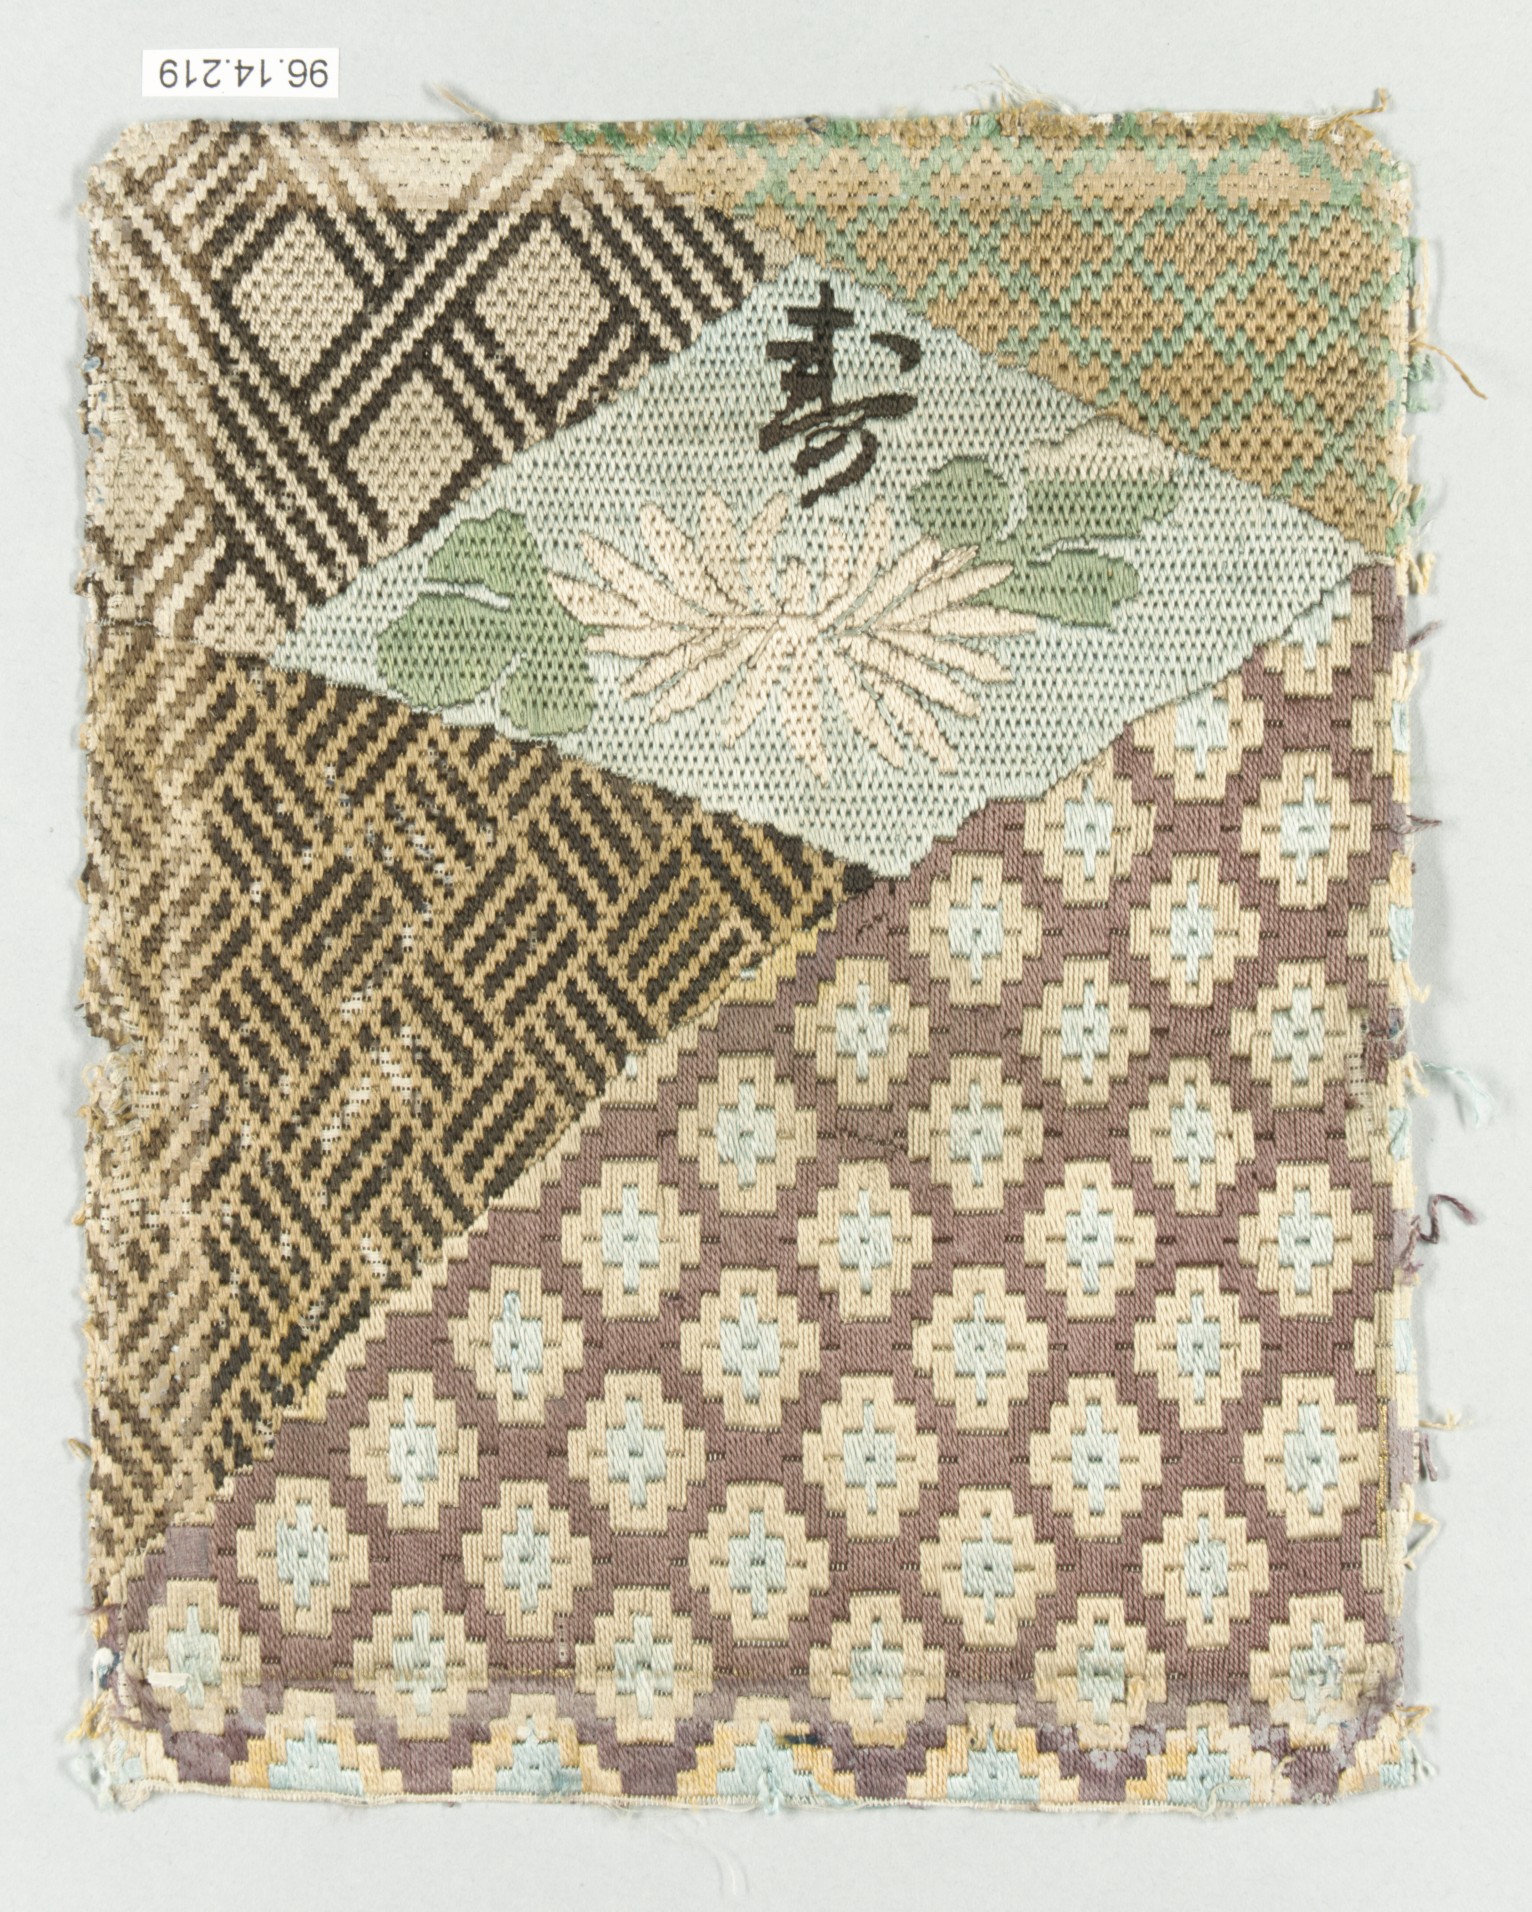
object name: piece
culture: japanese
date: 1801-1900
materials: silk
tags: leaves